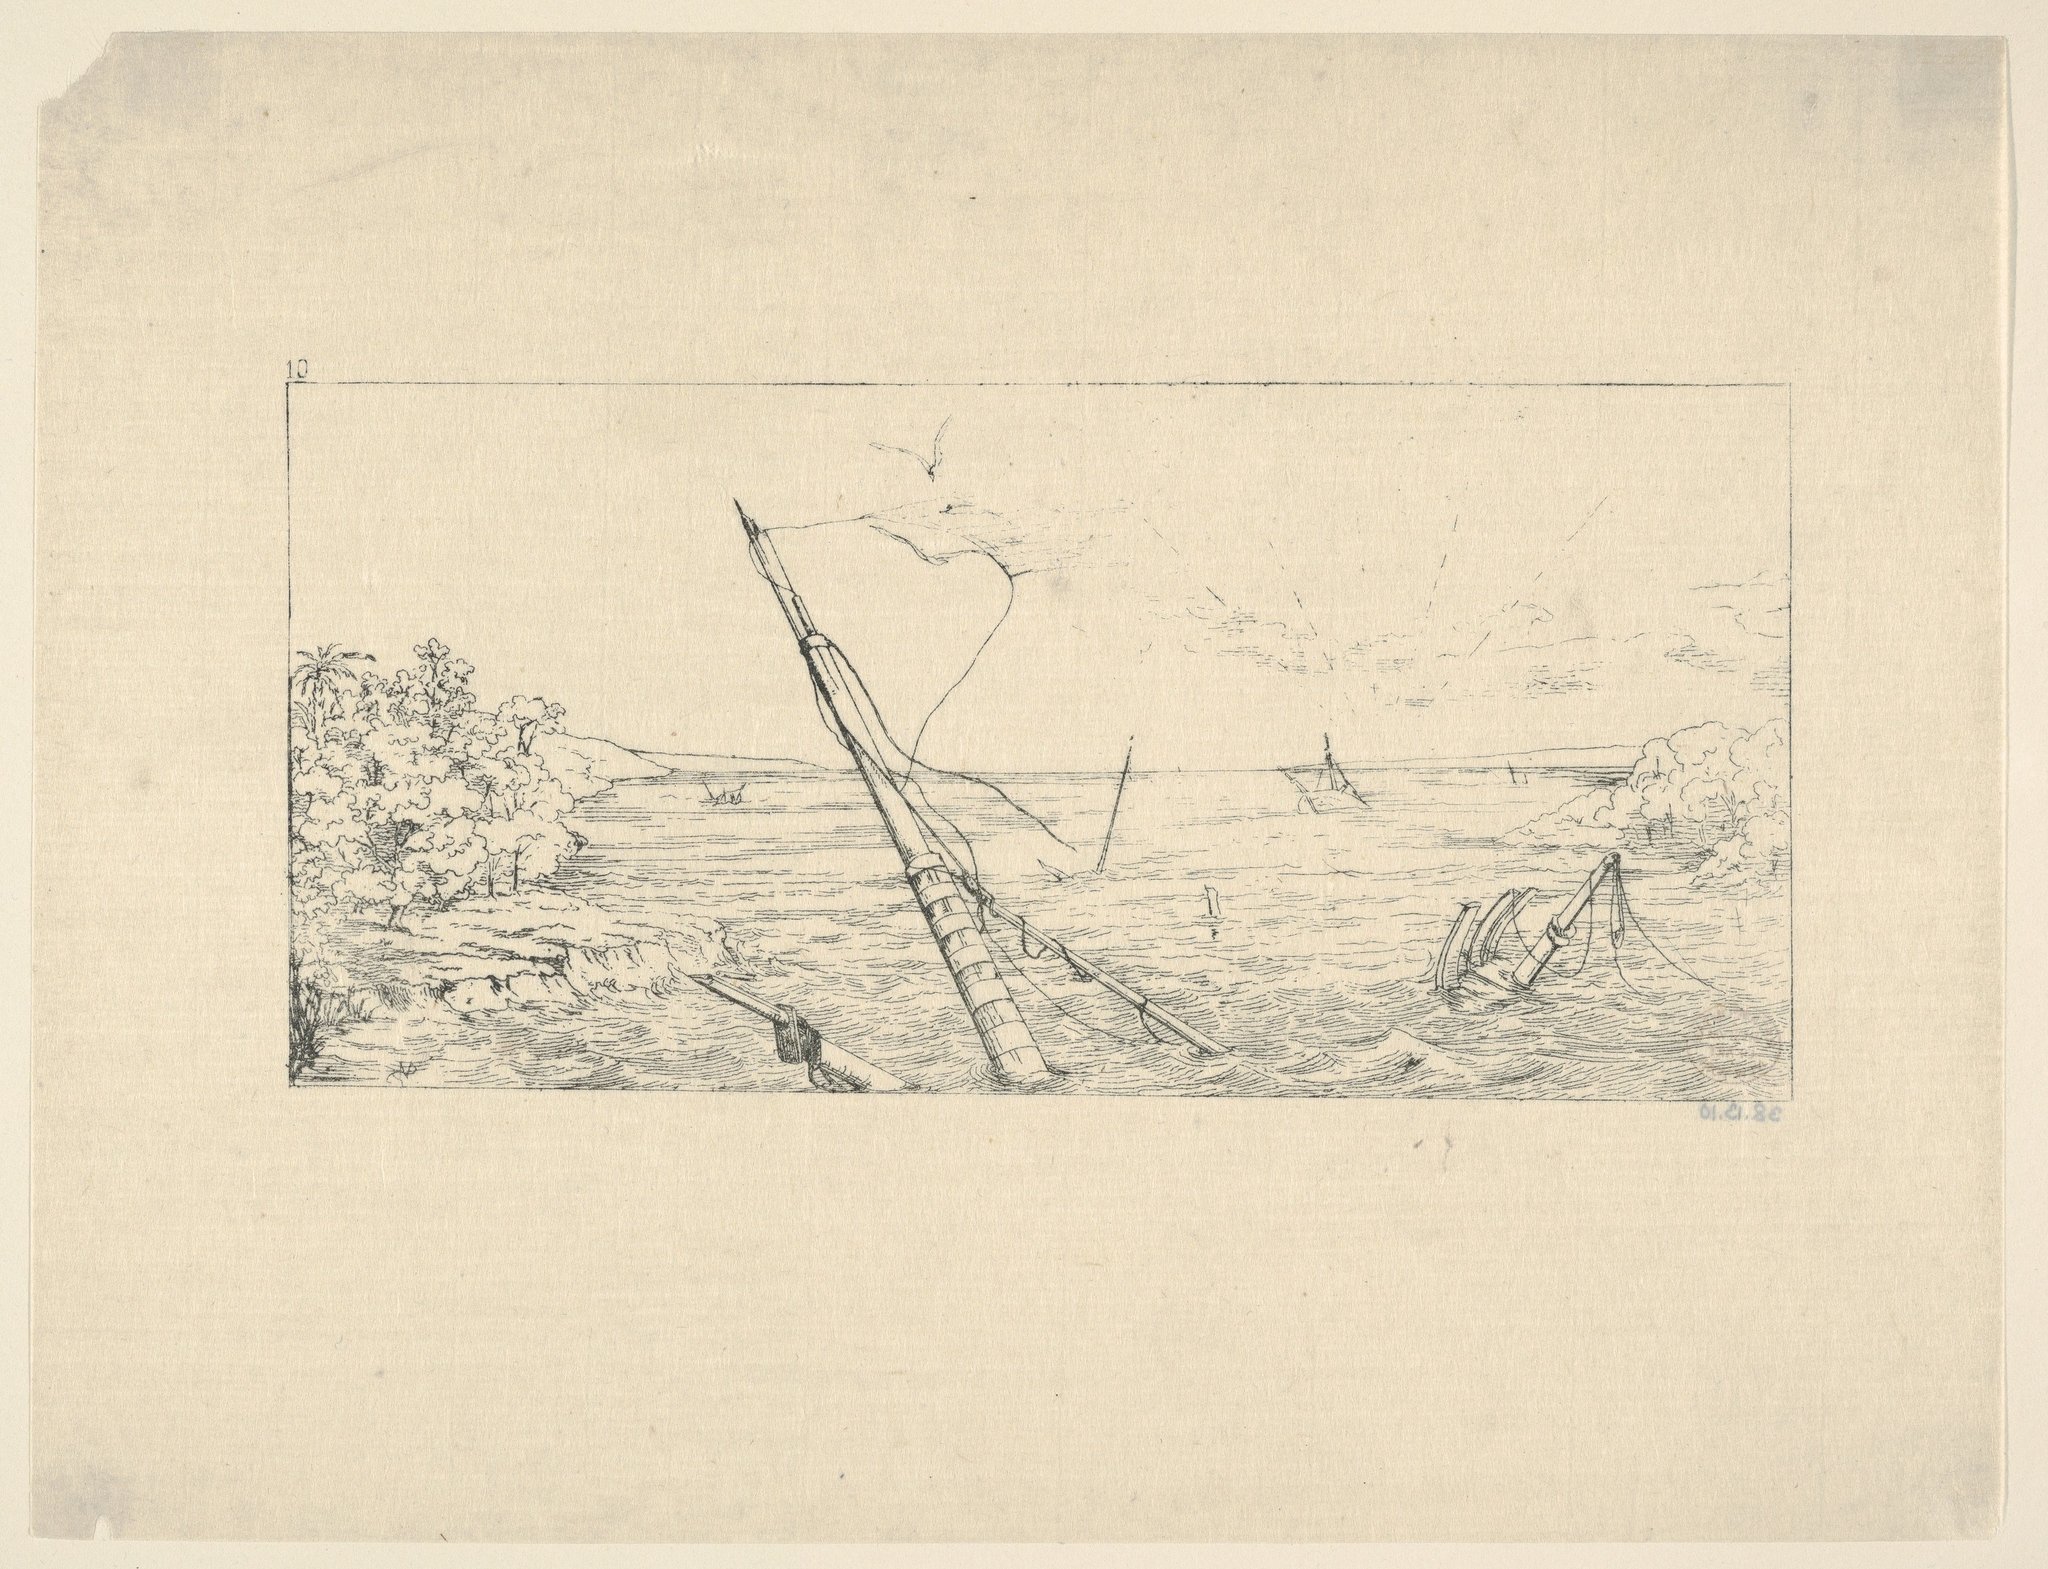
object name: print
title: Stone Blockade off Charleston, South Carolina (from Confederate War Etchings)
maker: adalbert john volck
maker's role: artist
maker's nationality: american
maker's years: 1828-1912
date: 1861-1863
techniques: etching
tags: american civil war,rivers,boats